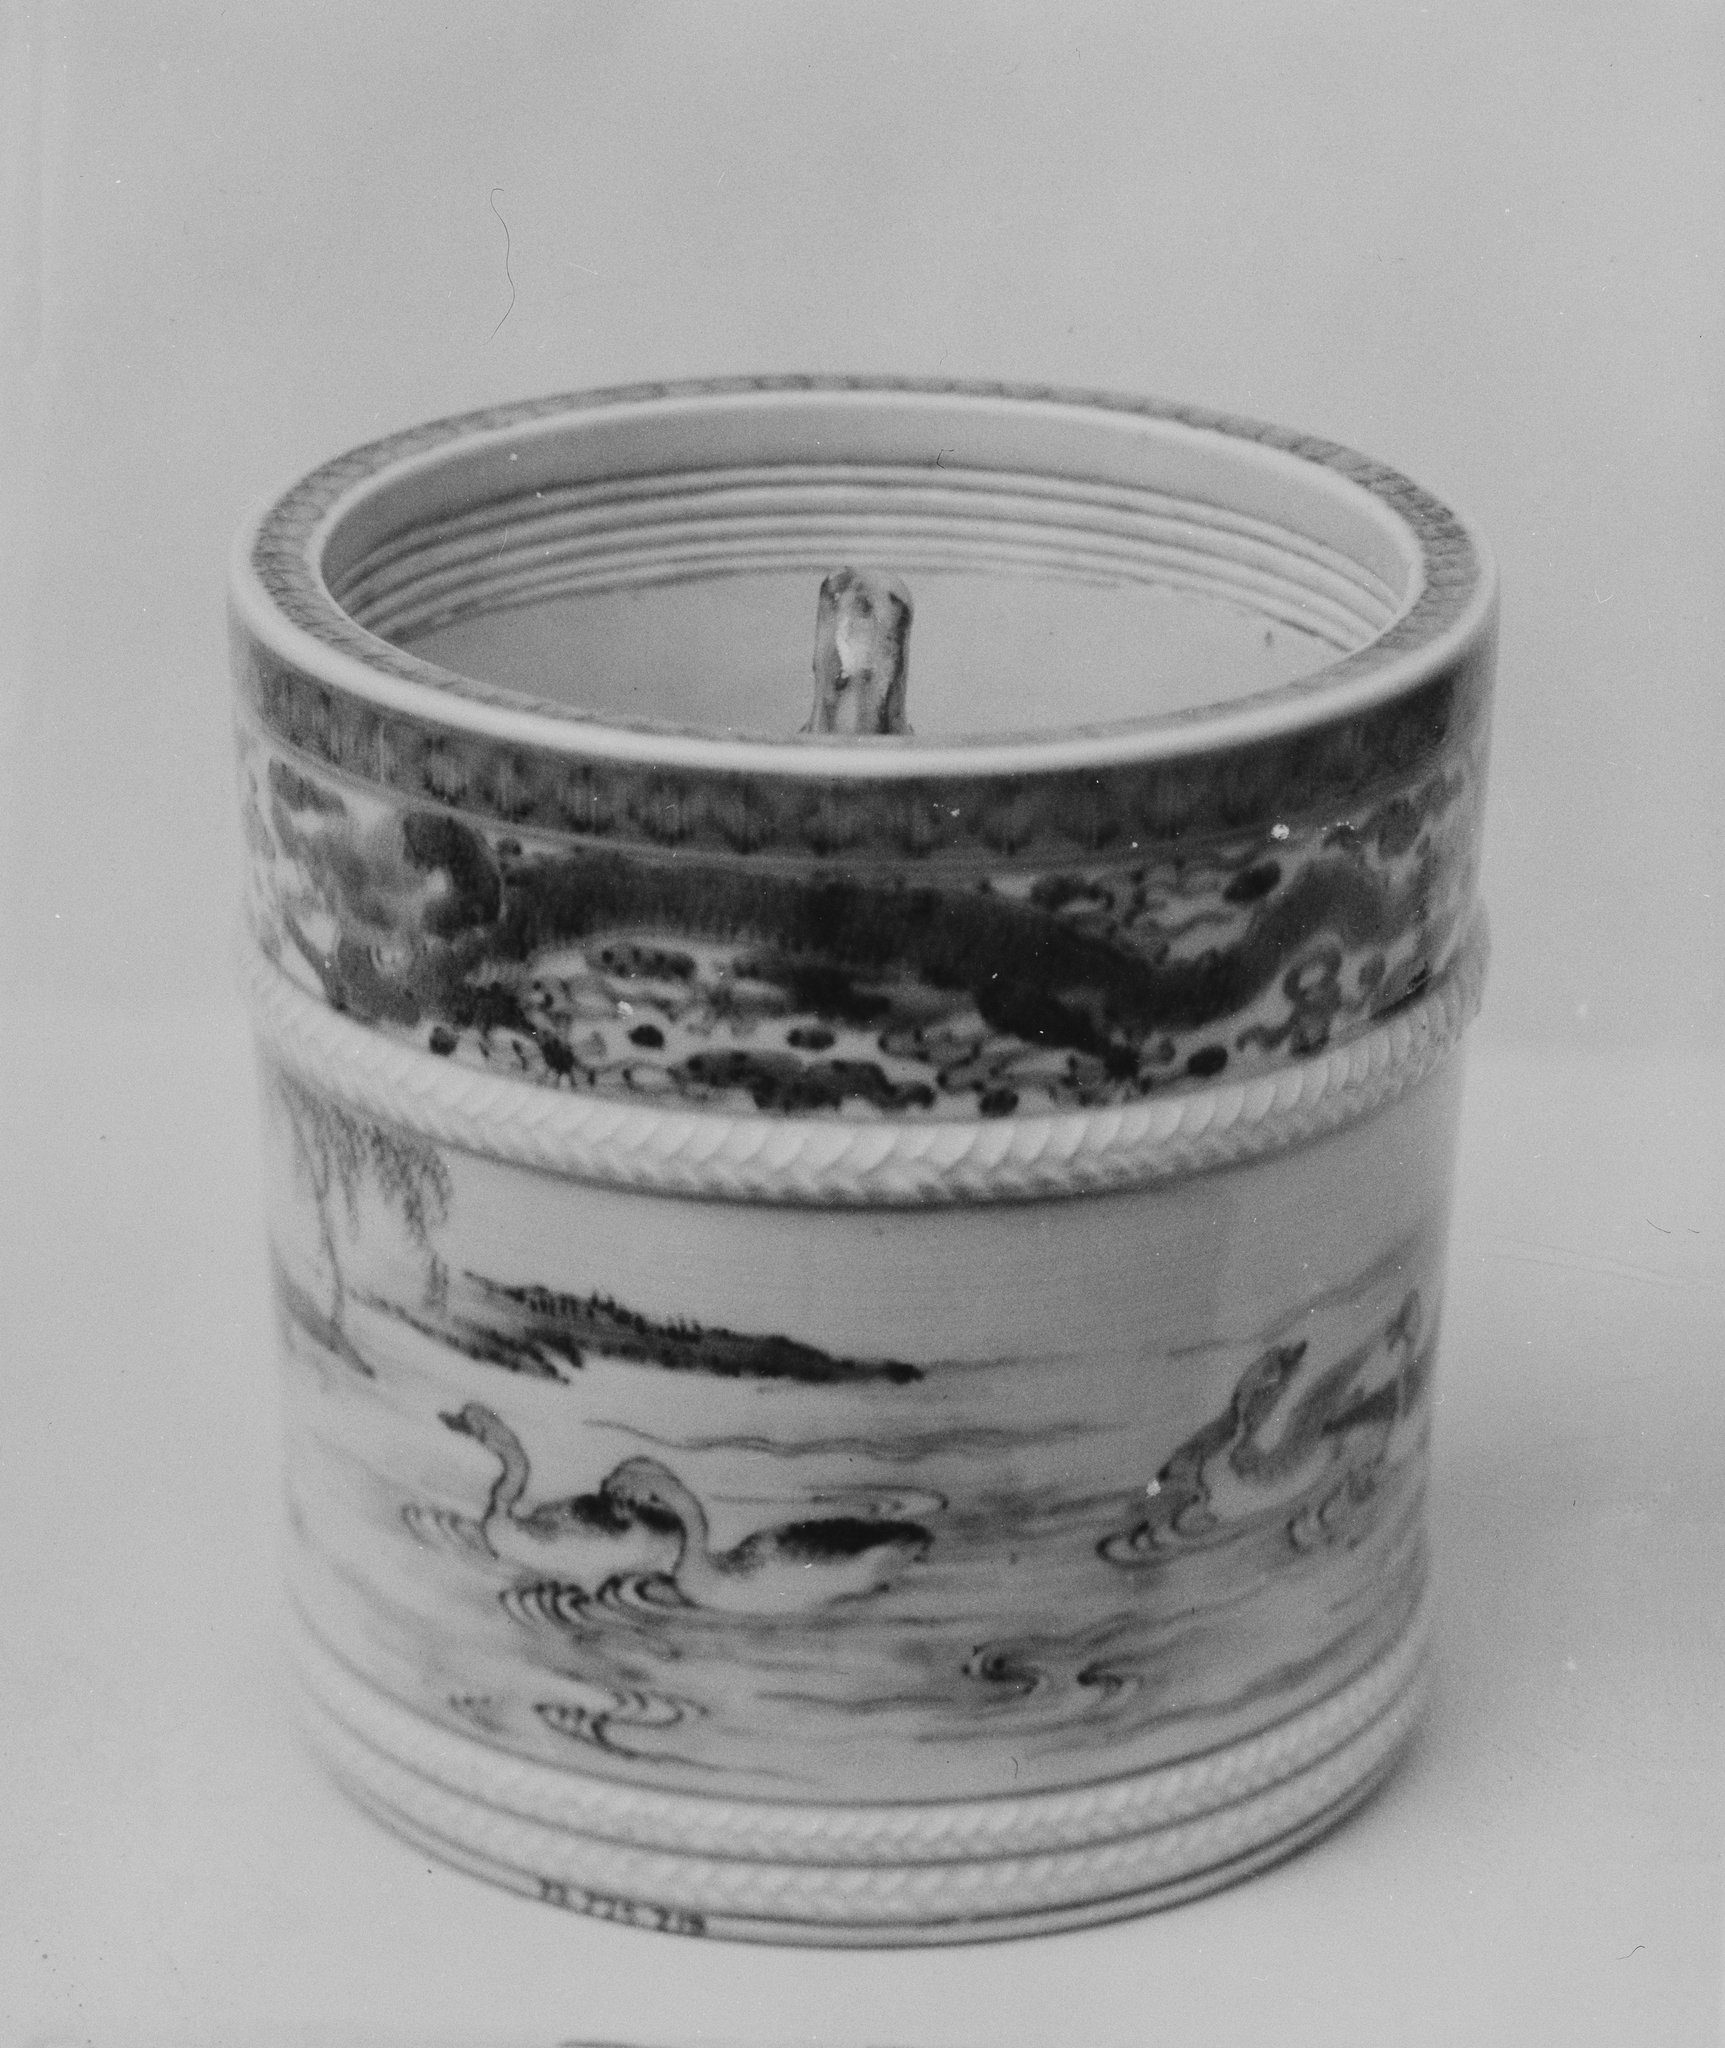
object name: bucket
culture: japanese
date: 1840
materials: porcelain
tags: ducks